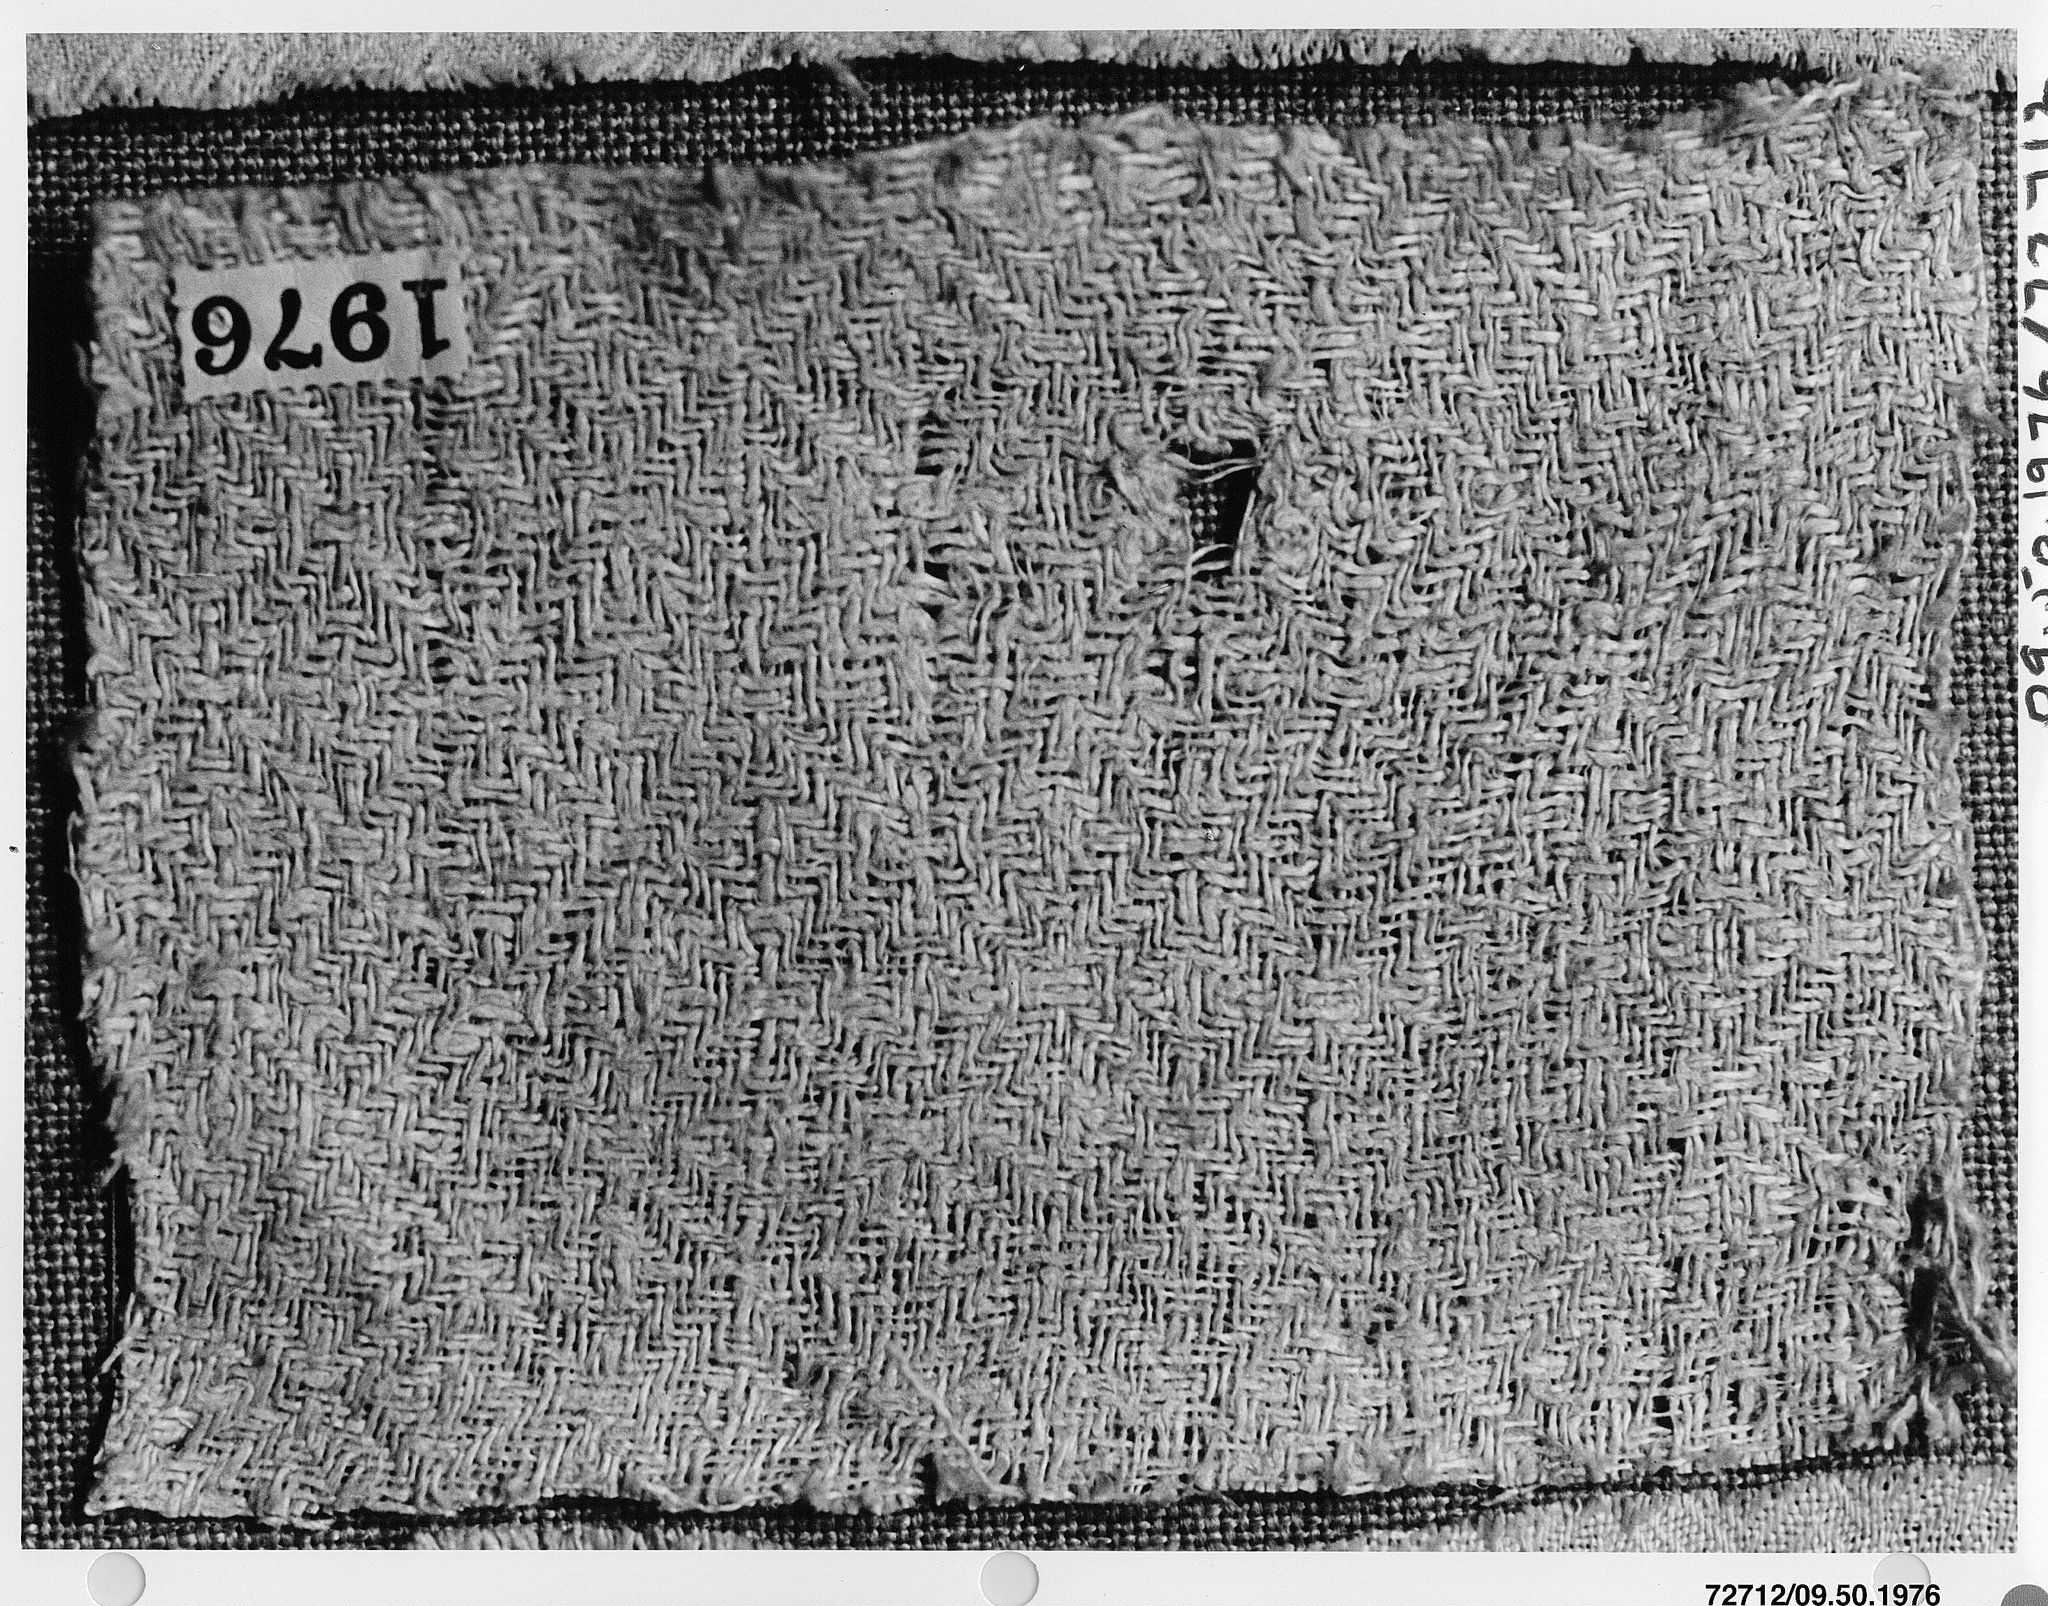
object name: piece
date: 1701-1900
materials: linen